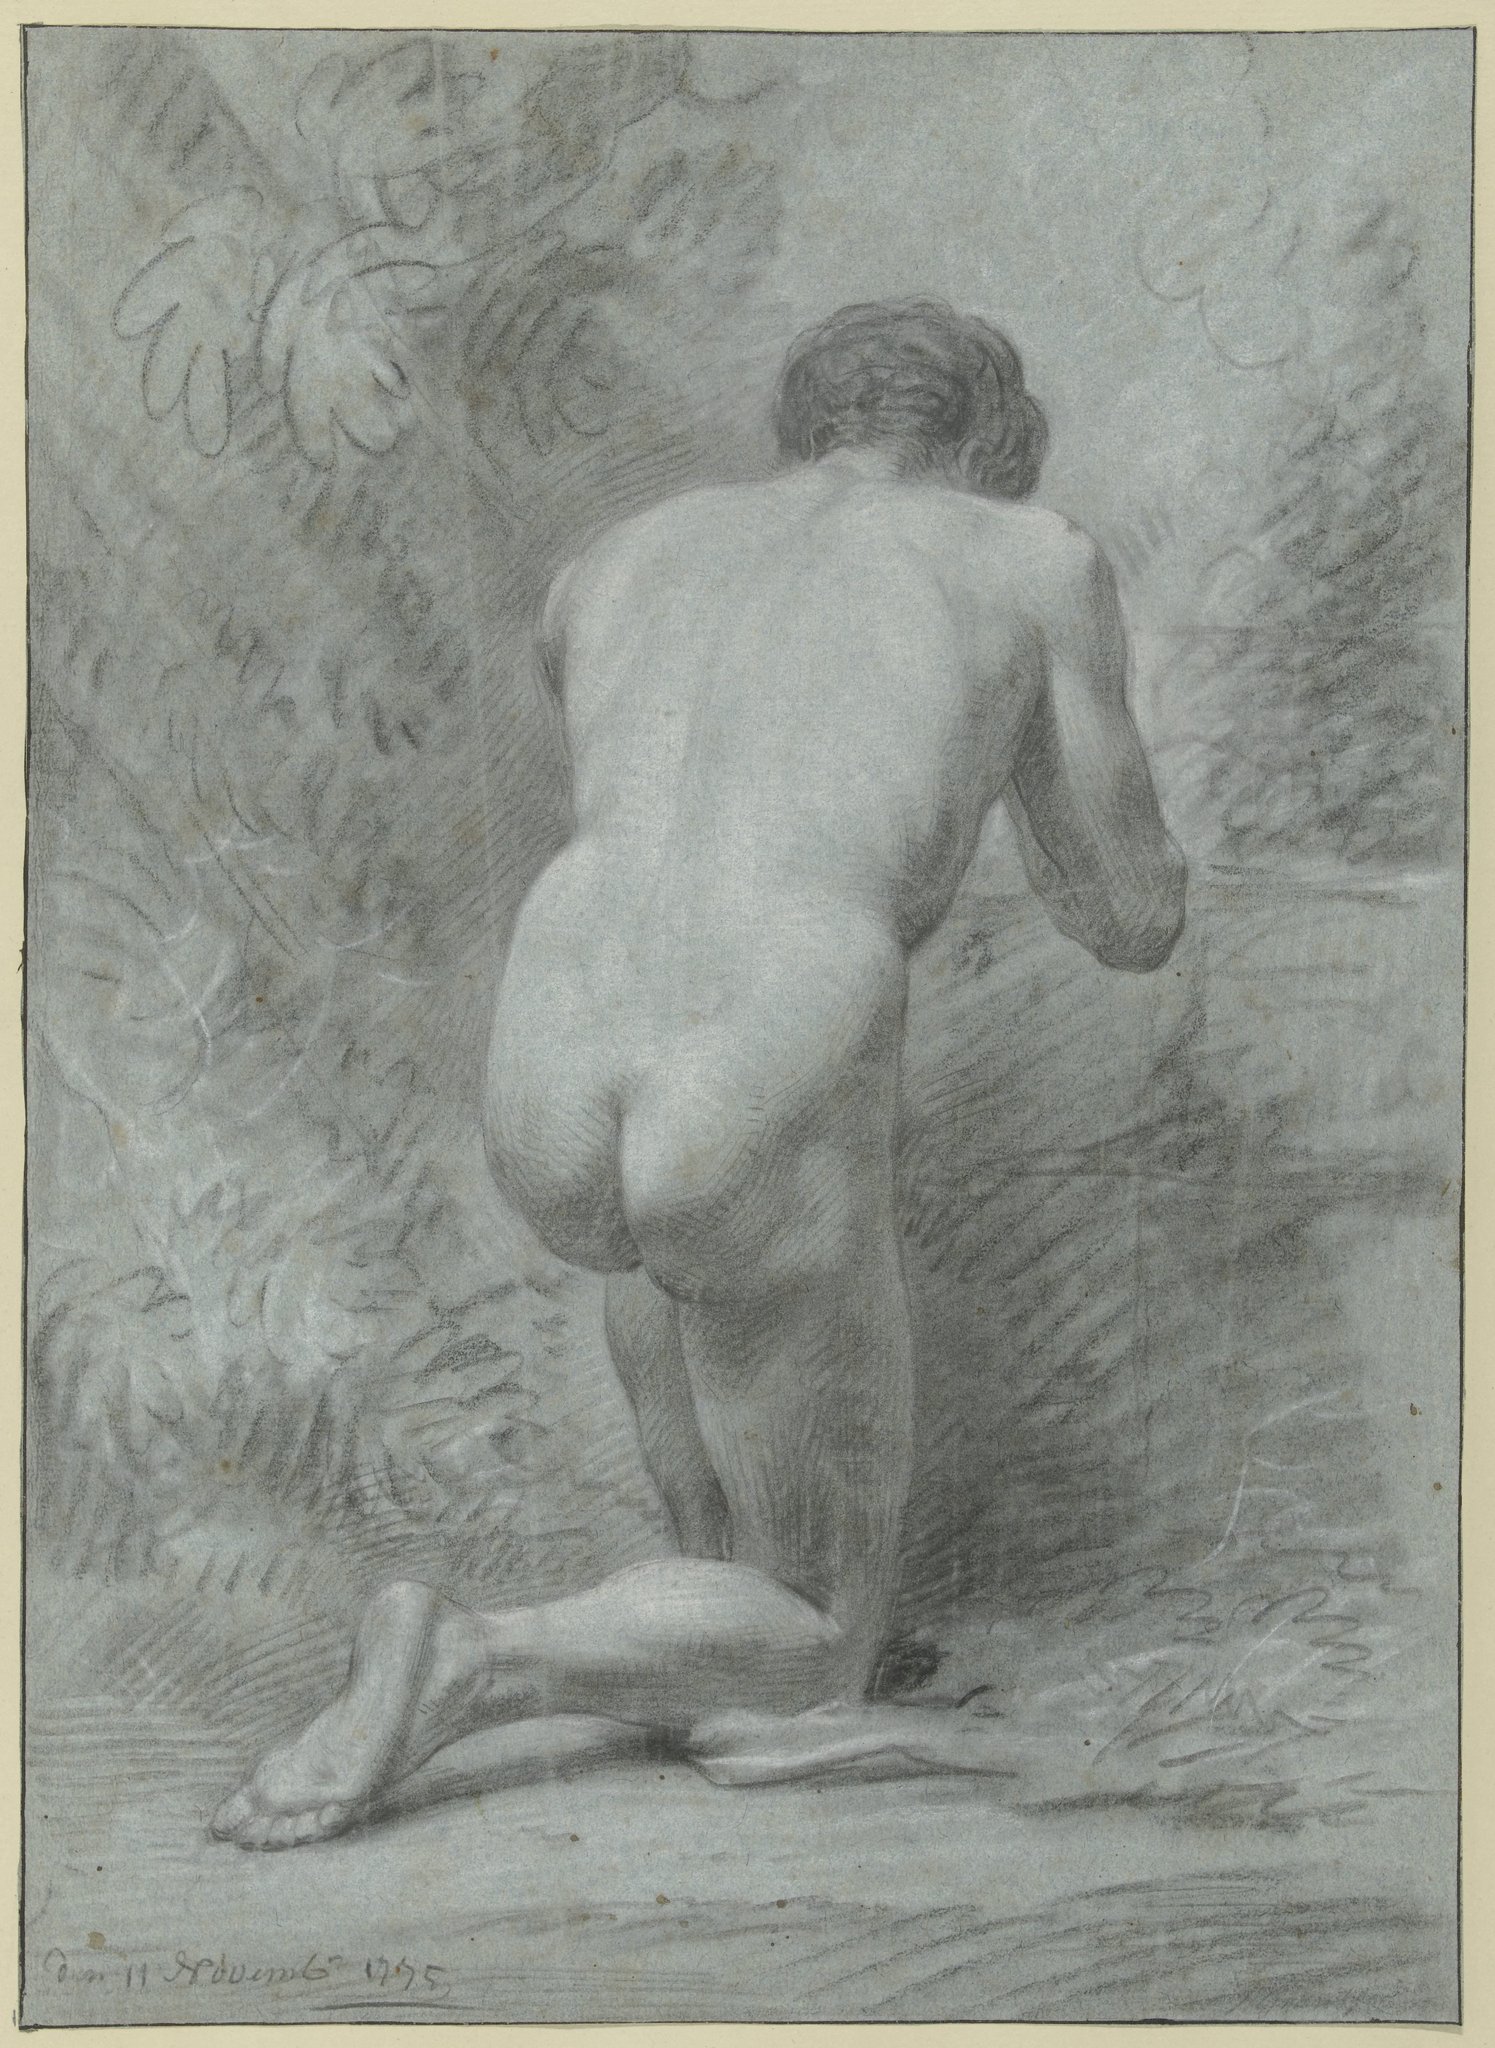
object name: drawing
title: Knielend mannelijk naakt, op de rug gezien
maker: jean grandjean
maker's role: draughtsman, print maker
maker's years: 1752-1781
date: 1775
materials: chalk, paper